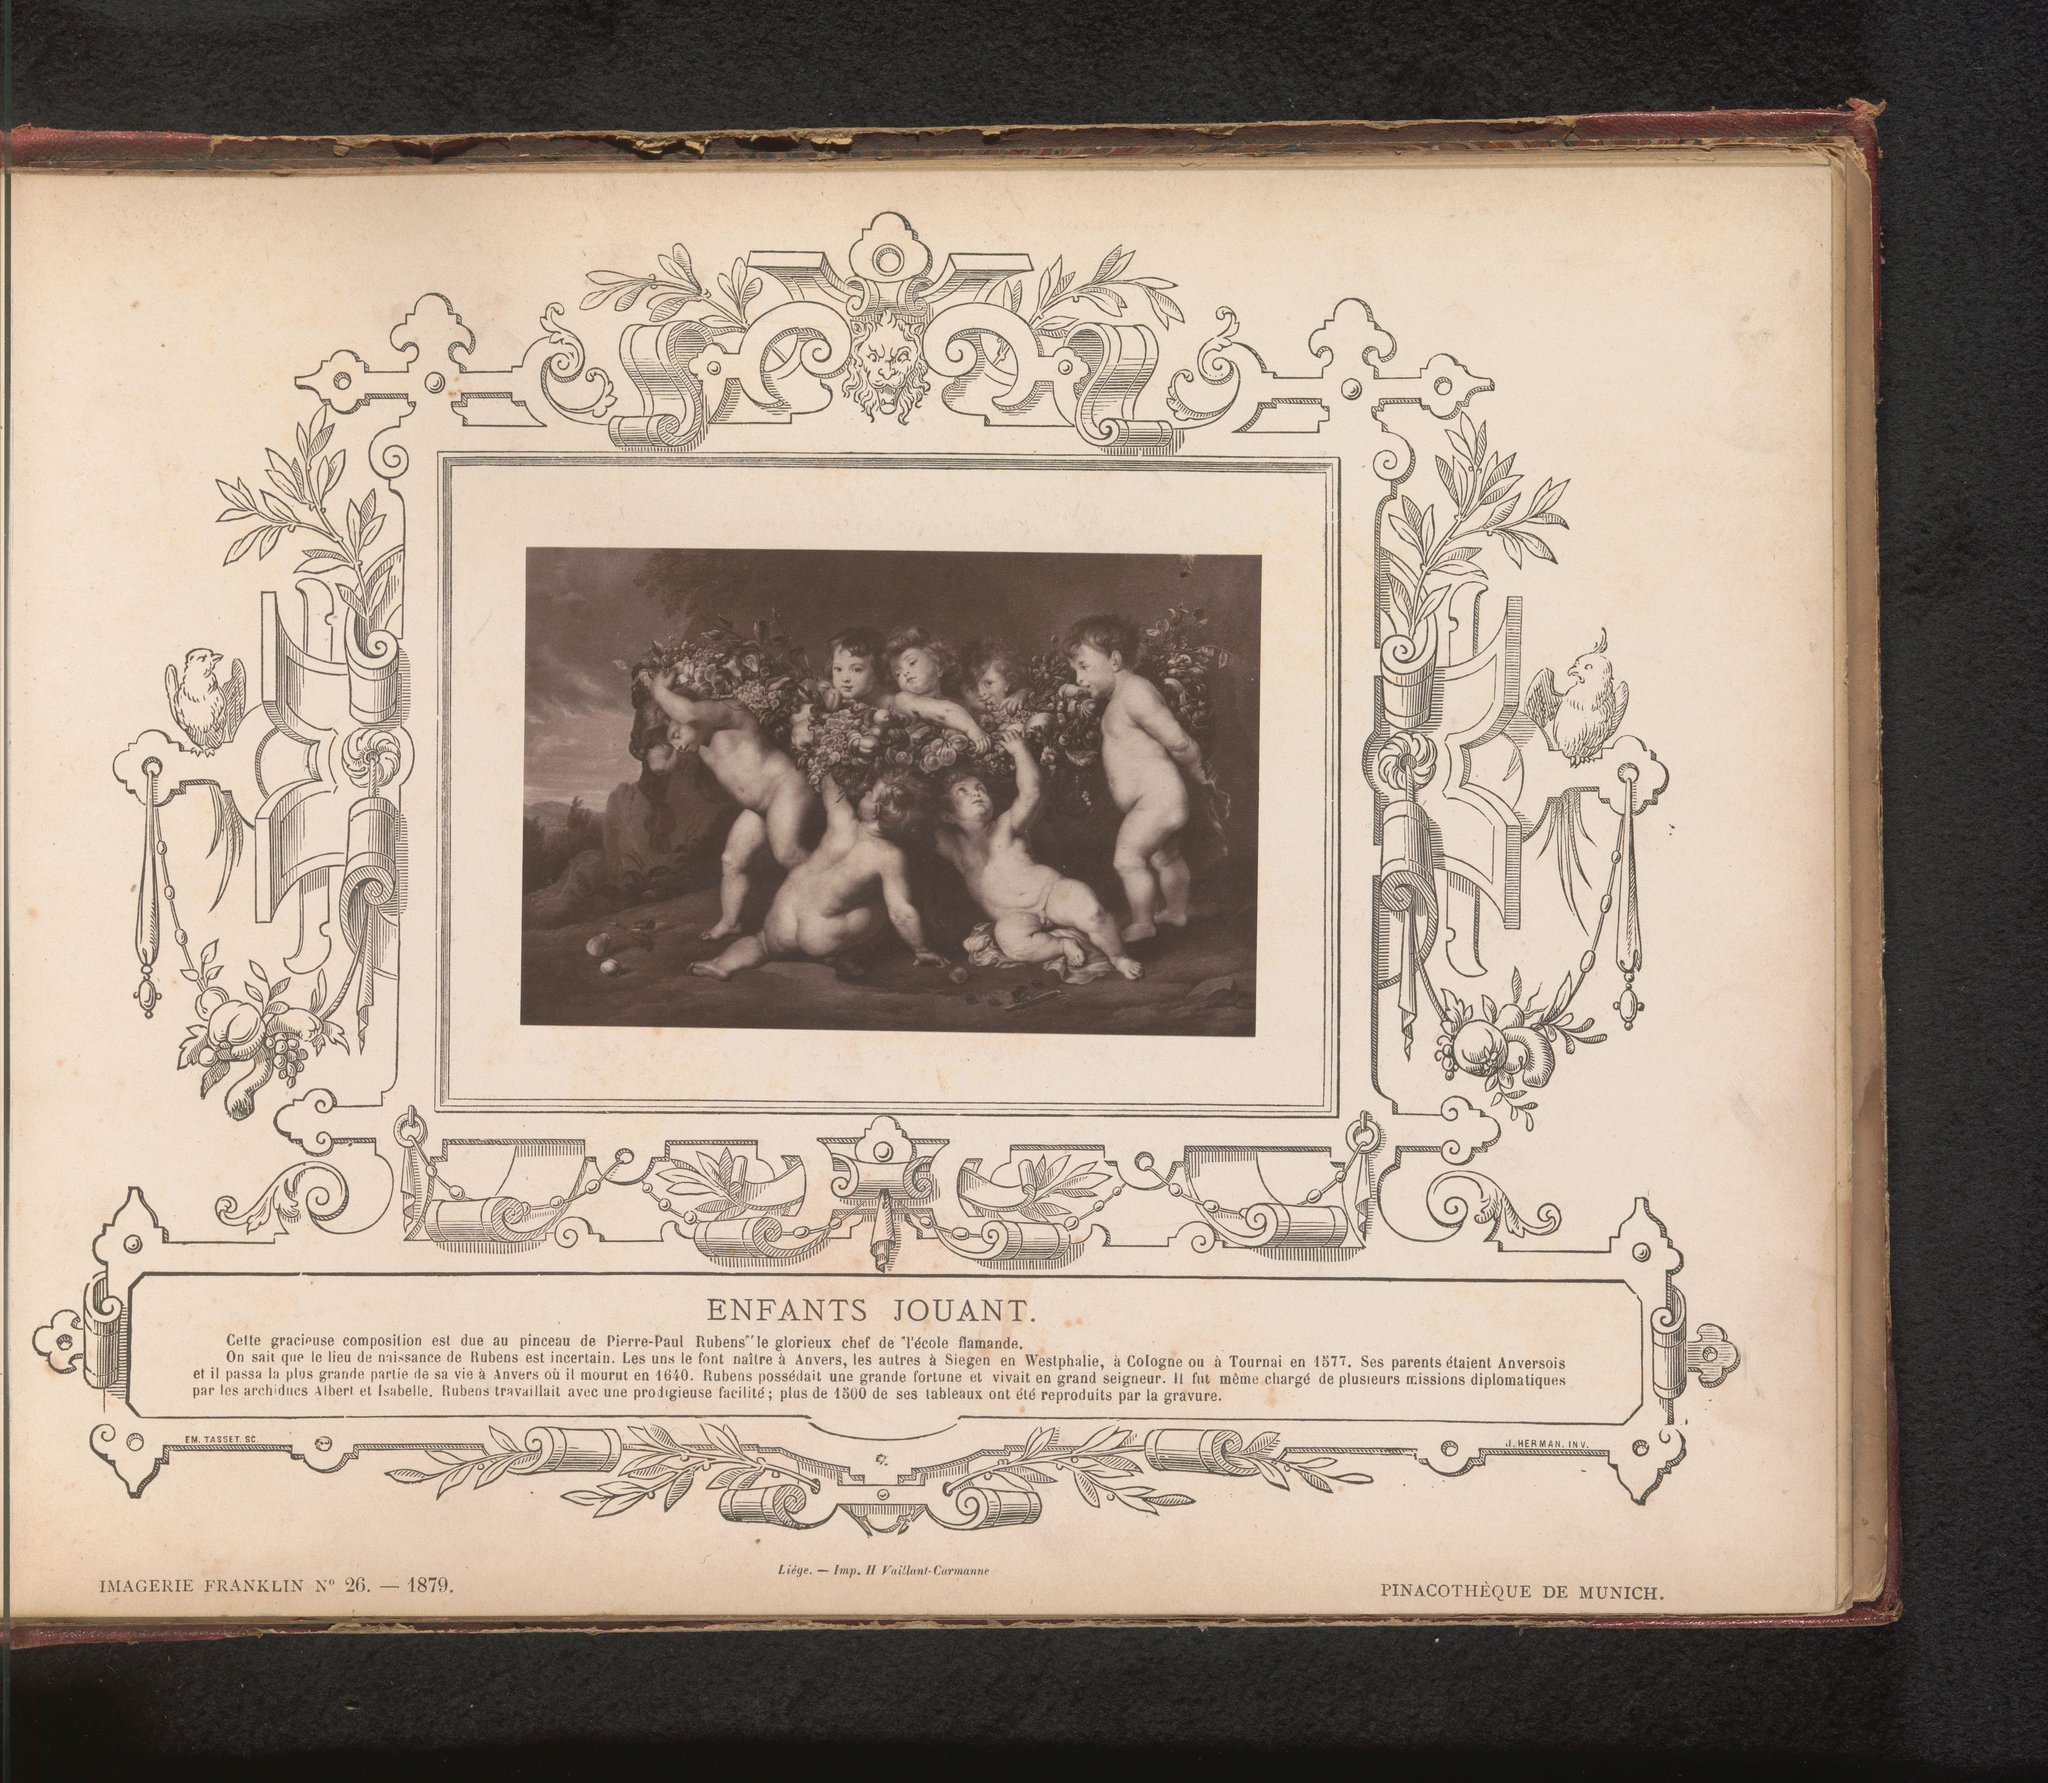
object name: reproduction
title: Reproductie van een schilderij van spelende kinderen door Peter Paul Rubens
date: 1874-1879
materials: paper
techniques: woodburytype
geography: liège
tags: children's games and plays, child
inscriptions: name: ‘EM. TASSET, SC.’, name: ‘J. HERMAN, INV.’, inscription: ‘PINACOTHÈQUE DE MUNICH.’, inscription: ‘IMAGERIE FRANKLIN No 26. -1879.’, inscription: ‘Cette gracieuse (...) la gravure.’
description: Deze prent maakt deel uit van een album.